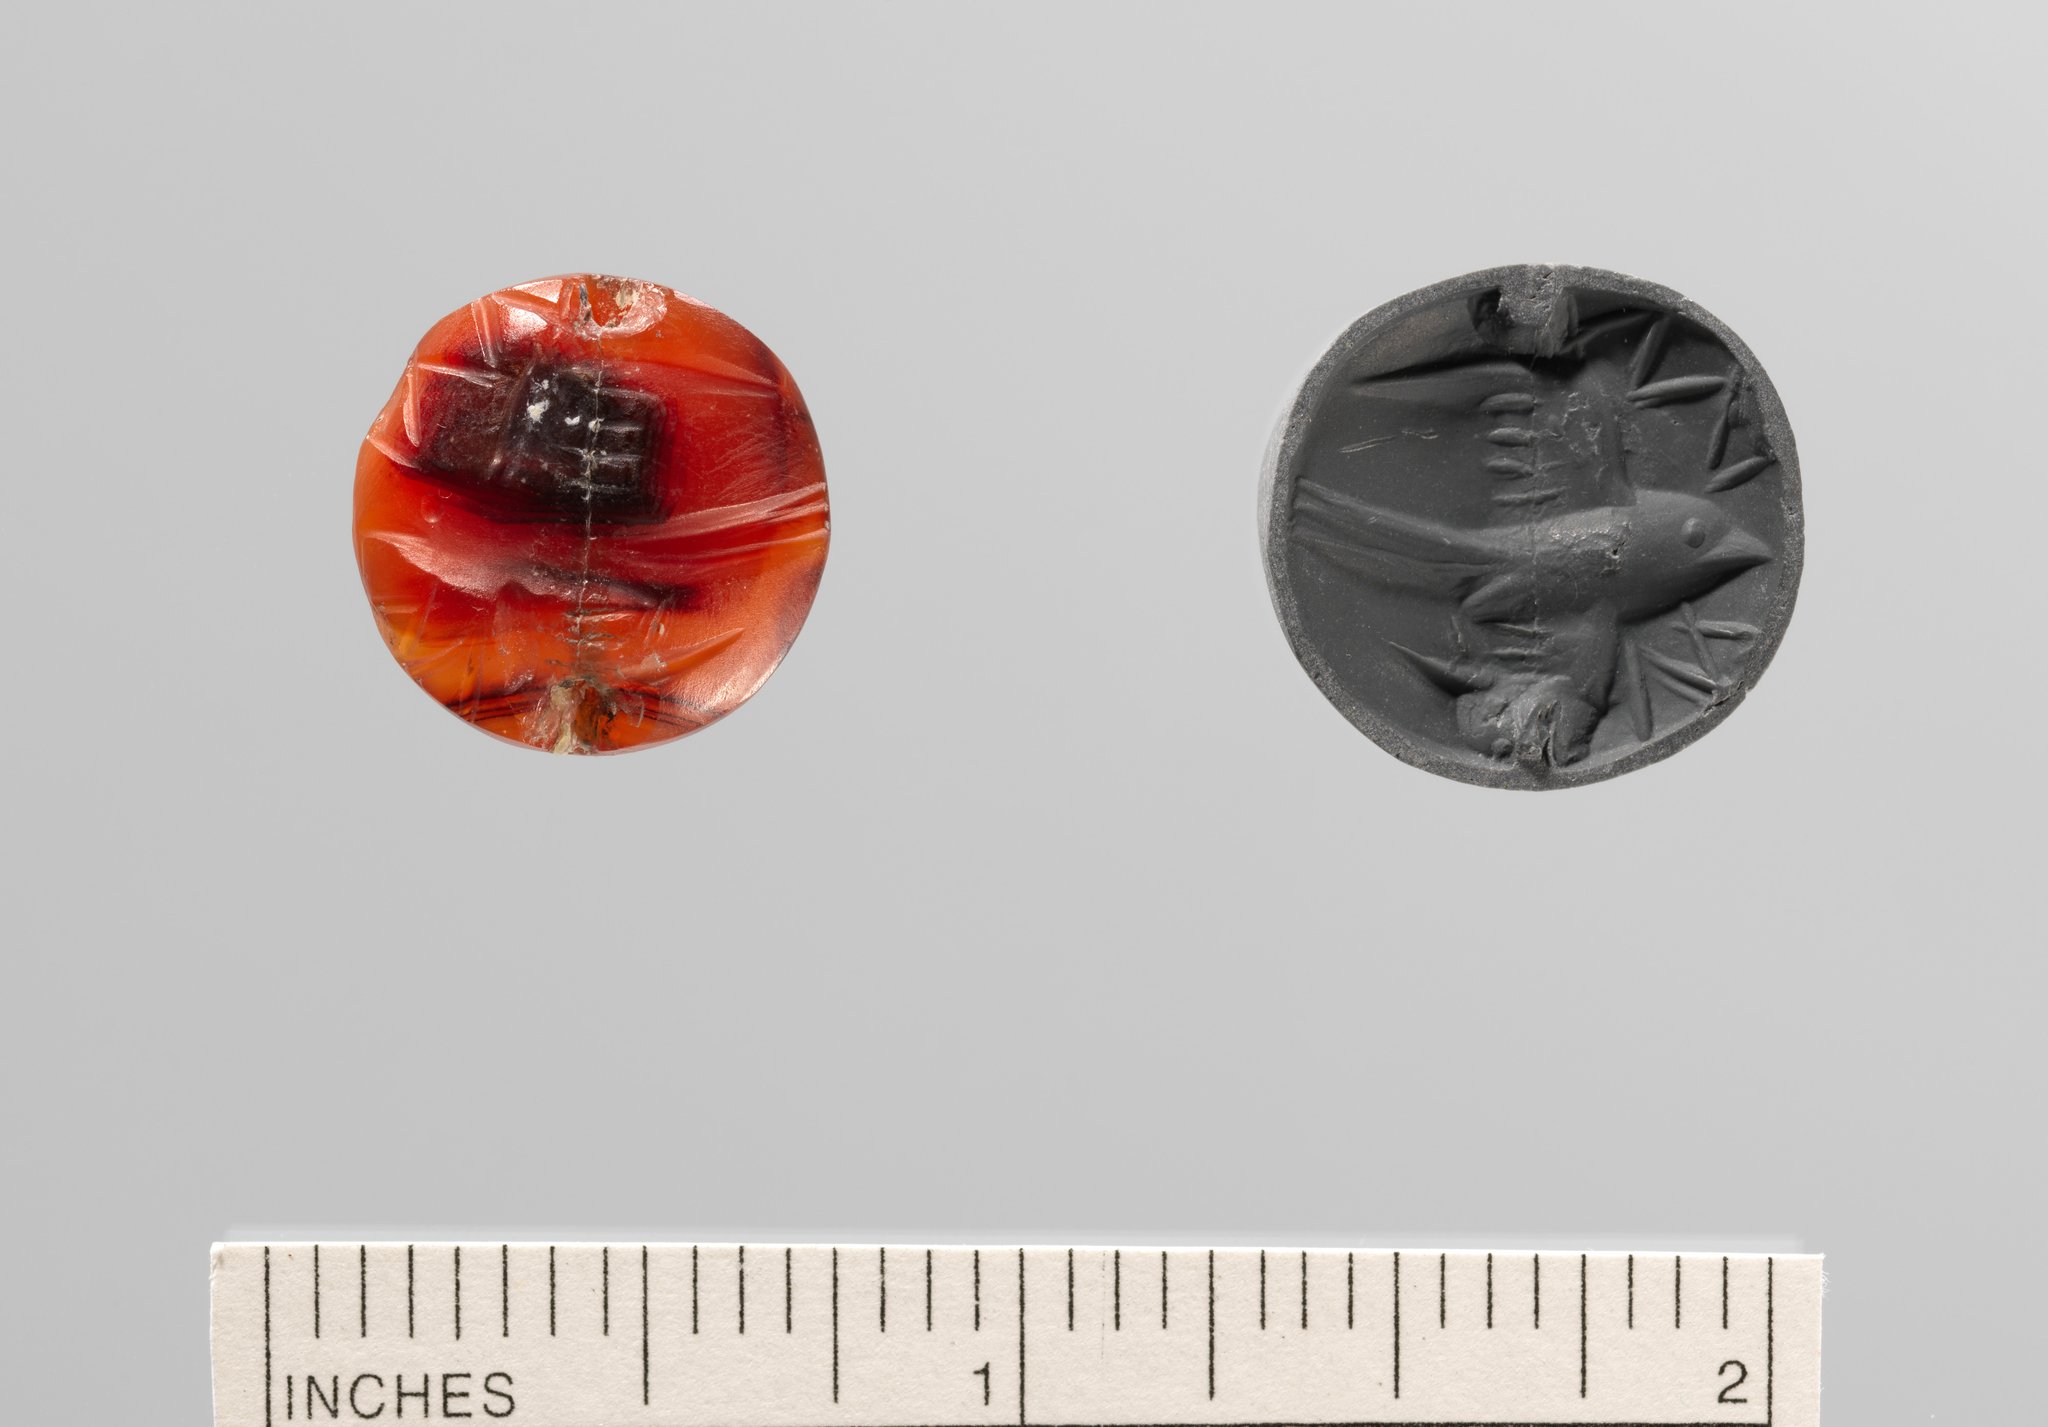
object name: seal, lentoid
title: Carnelian Lentoid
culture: minoan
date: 1600-1450 BCE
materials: gemstone